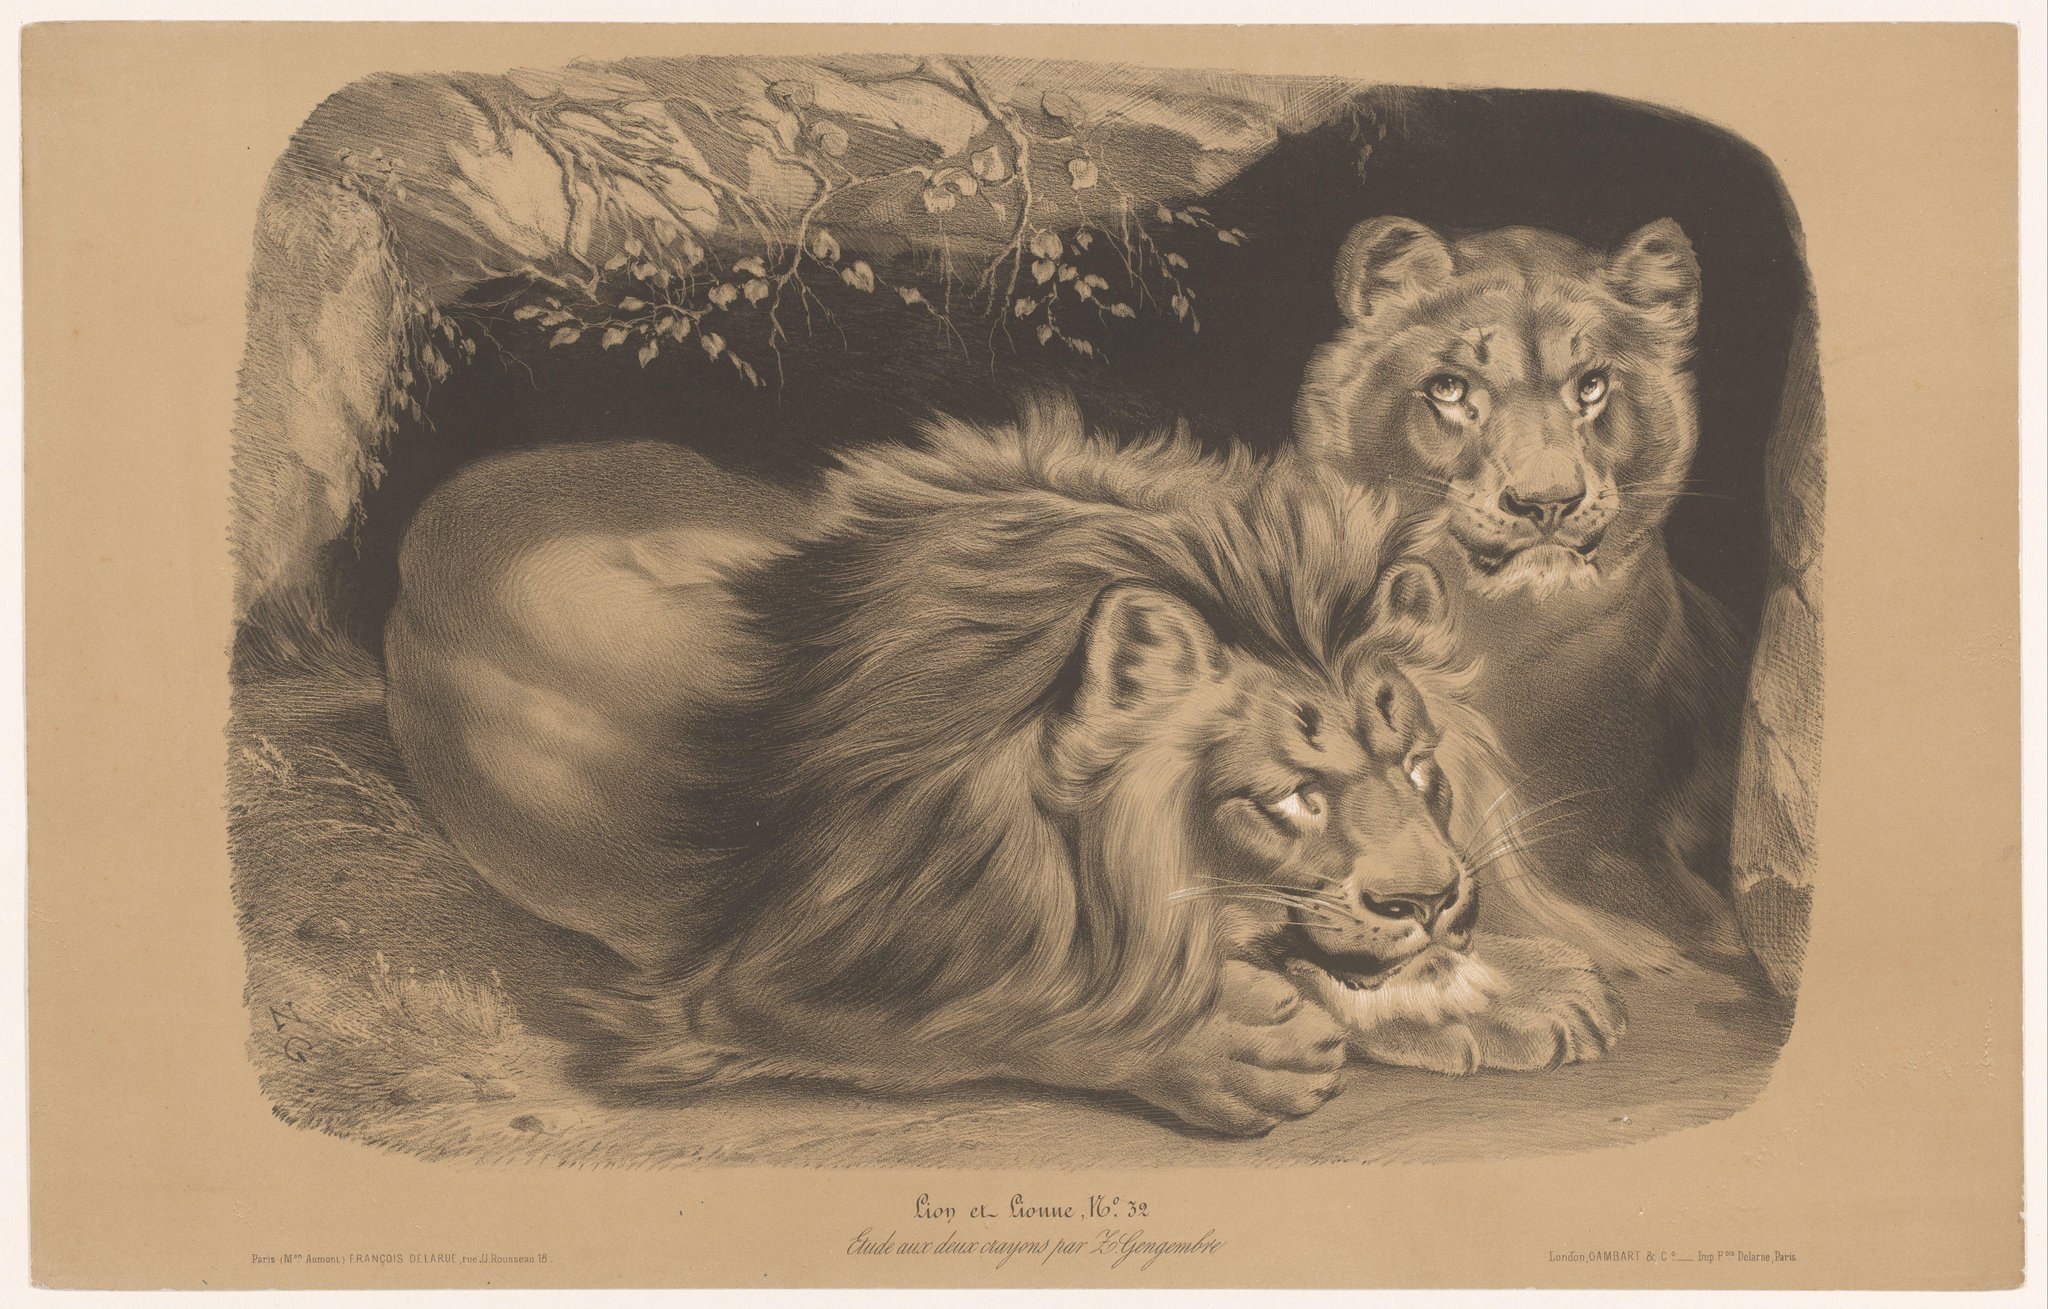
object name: print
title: Étude aux deux crayons par Z. Gengembre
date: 1850-1870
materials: paper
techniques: lithography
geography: paris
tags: beasts of prey, predatory animals: lion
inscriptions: collector's mark: Lugt 2228a